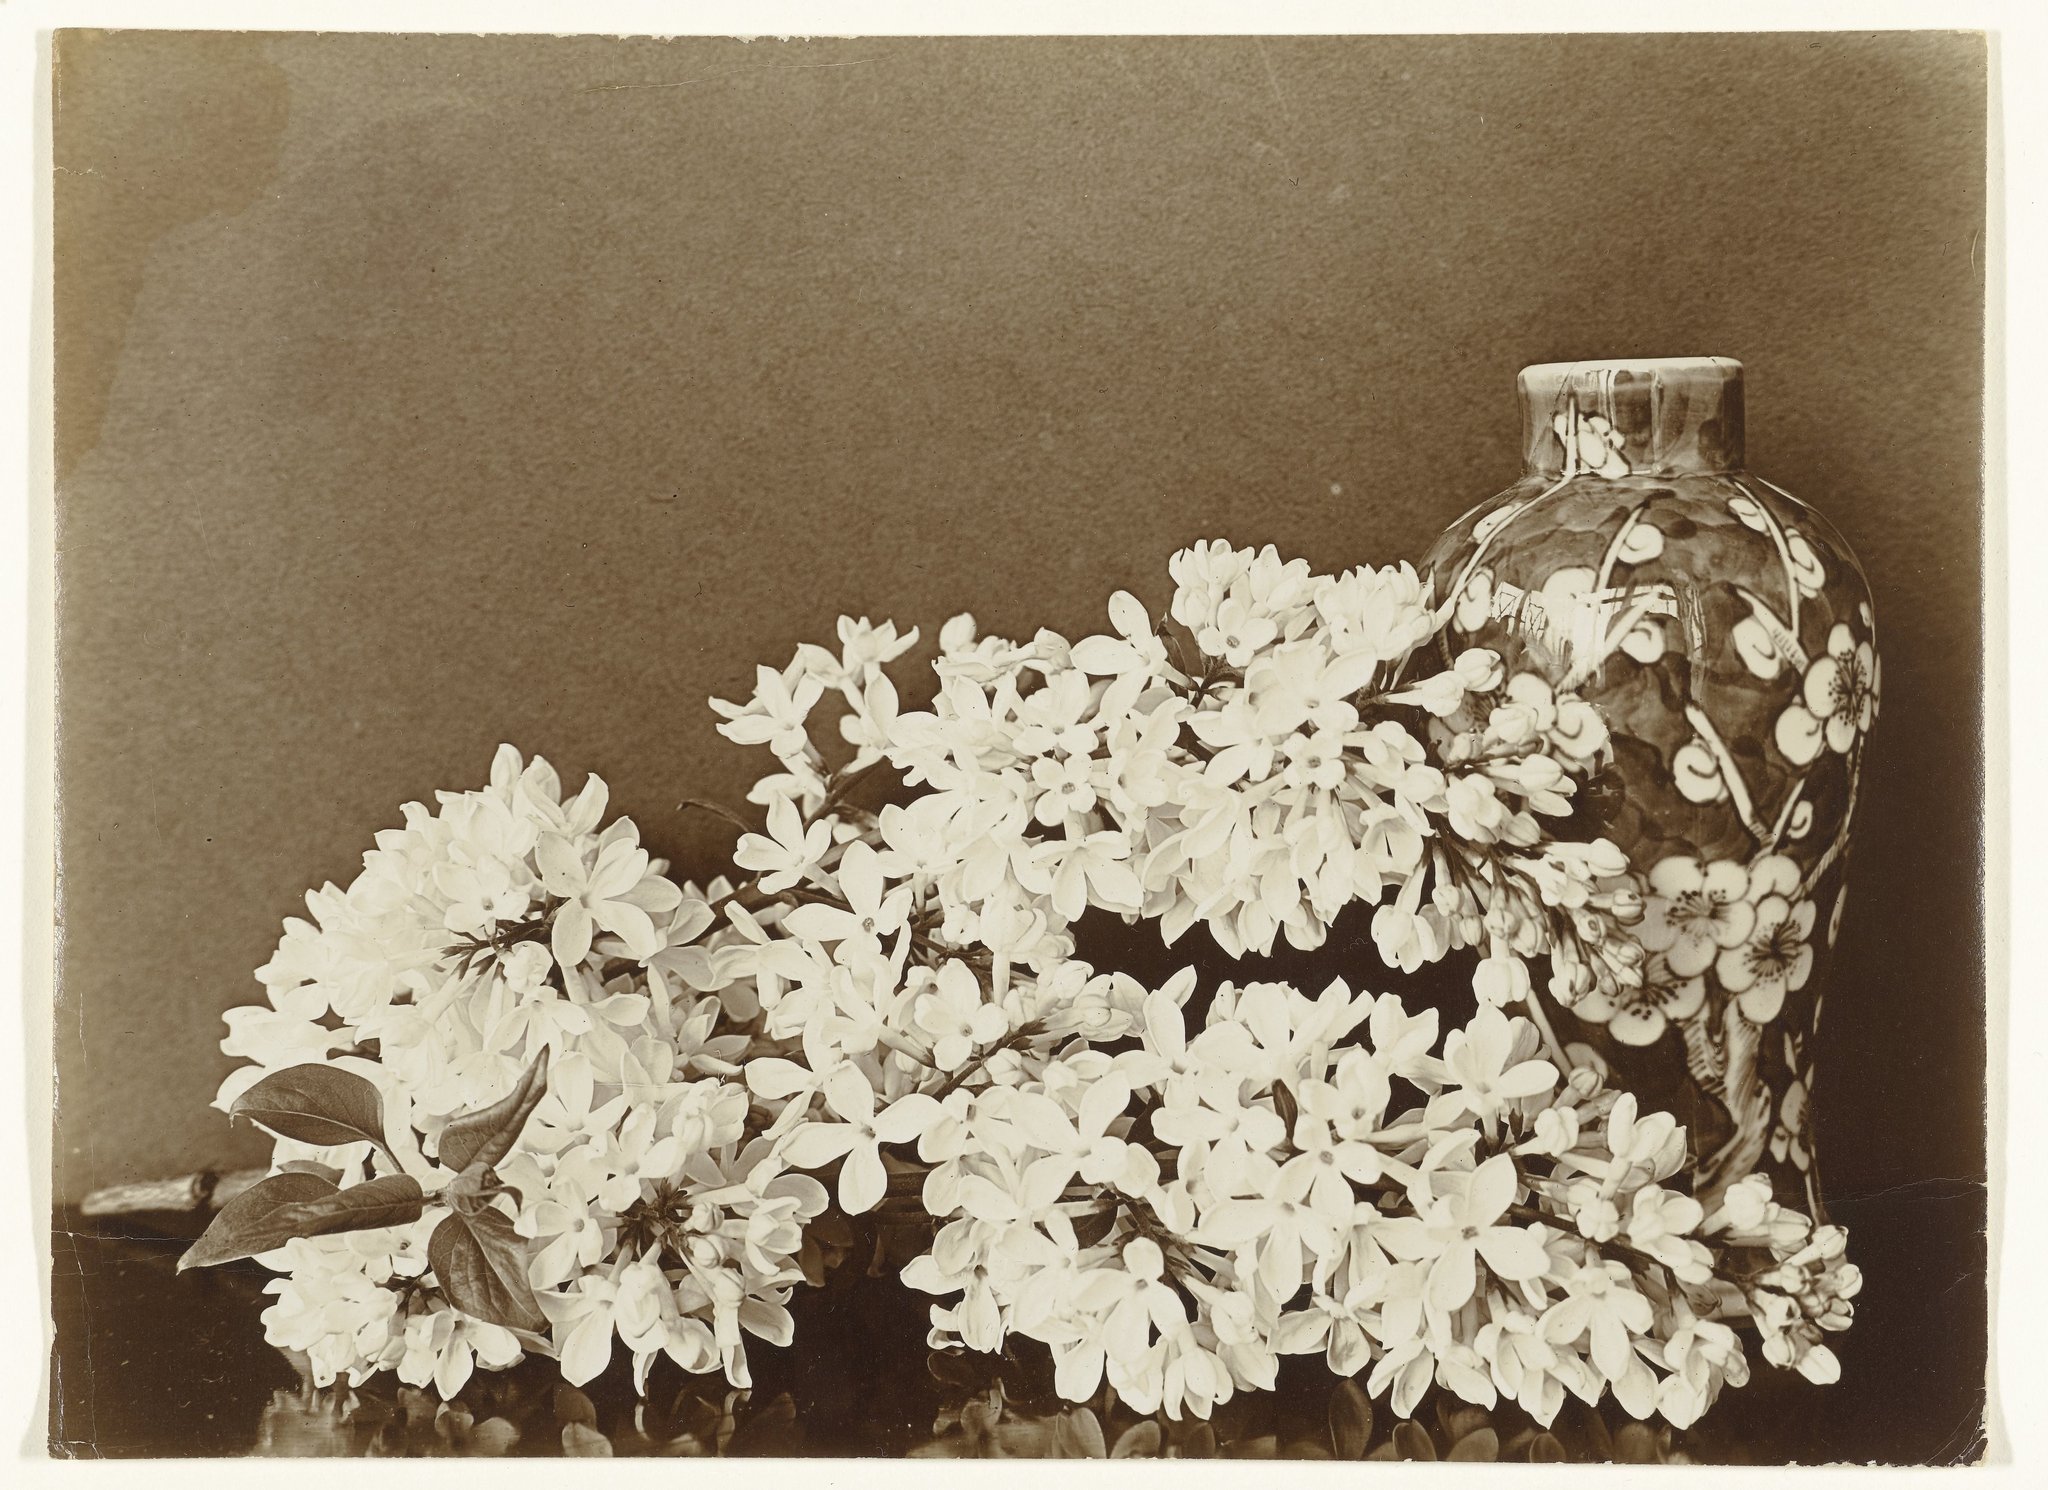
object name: photograph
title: Stilleven met seringen en vaas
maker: richard tepe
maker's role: fotograaf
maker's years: 1864-1952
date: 1910-1930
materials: paper, photographic support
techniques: gelatin silver print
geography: netherlands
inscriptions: annotation: ‘Still-leben / von Flieder (Syringa vulgaris / Blüthe-zweeige einfachblühend / Marie Legraye / Stil leven / van de enkelbloemige Sering / "Marie Legraye"’, signature: ‘foto R. Tepe Apeldoorn Holland’